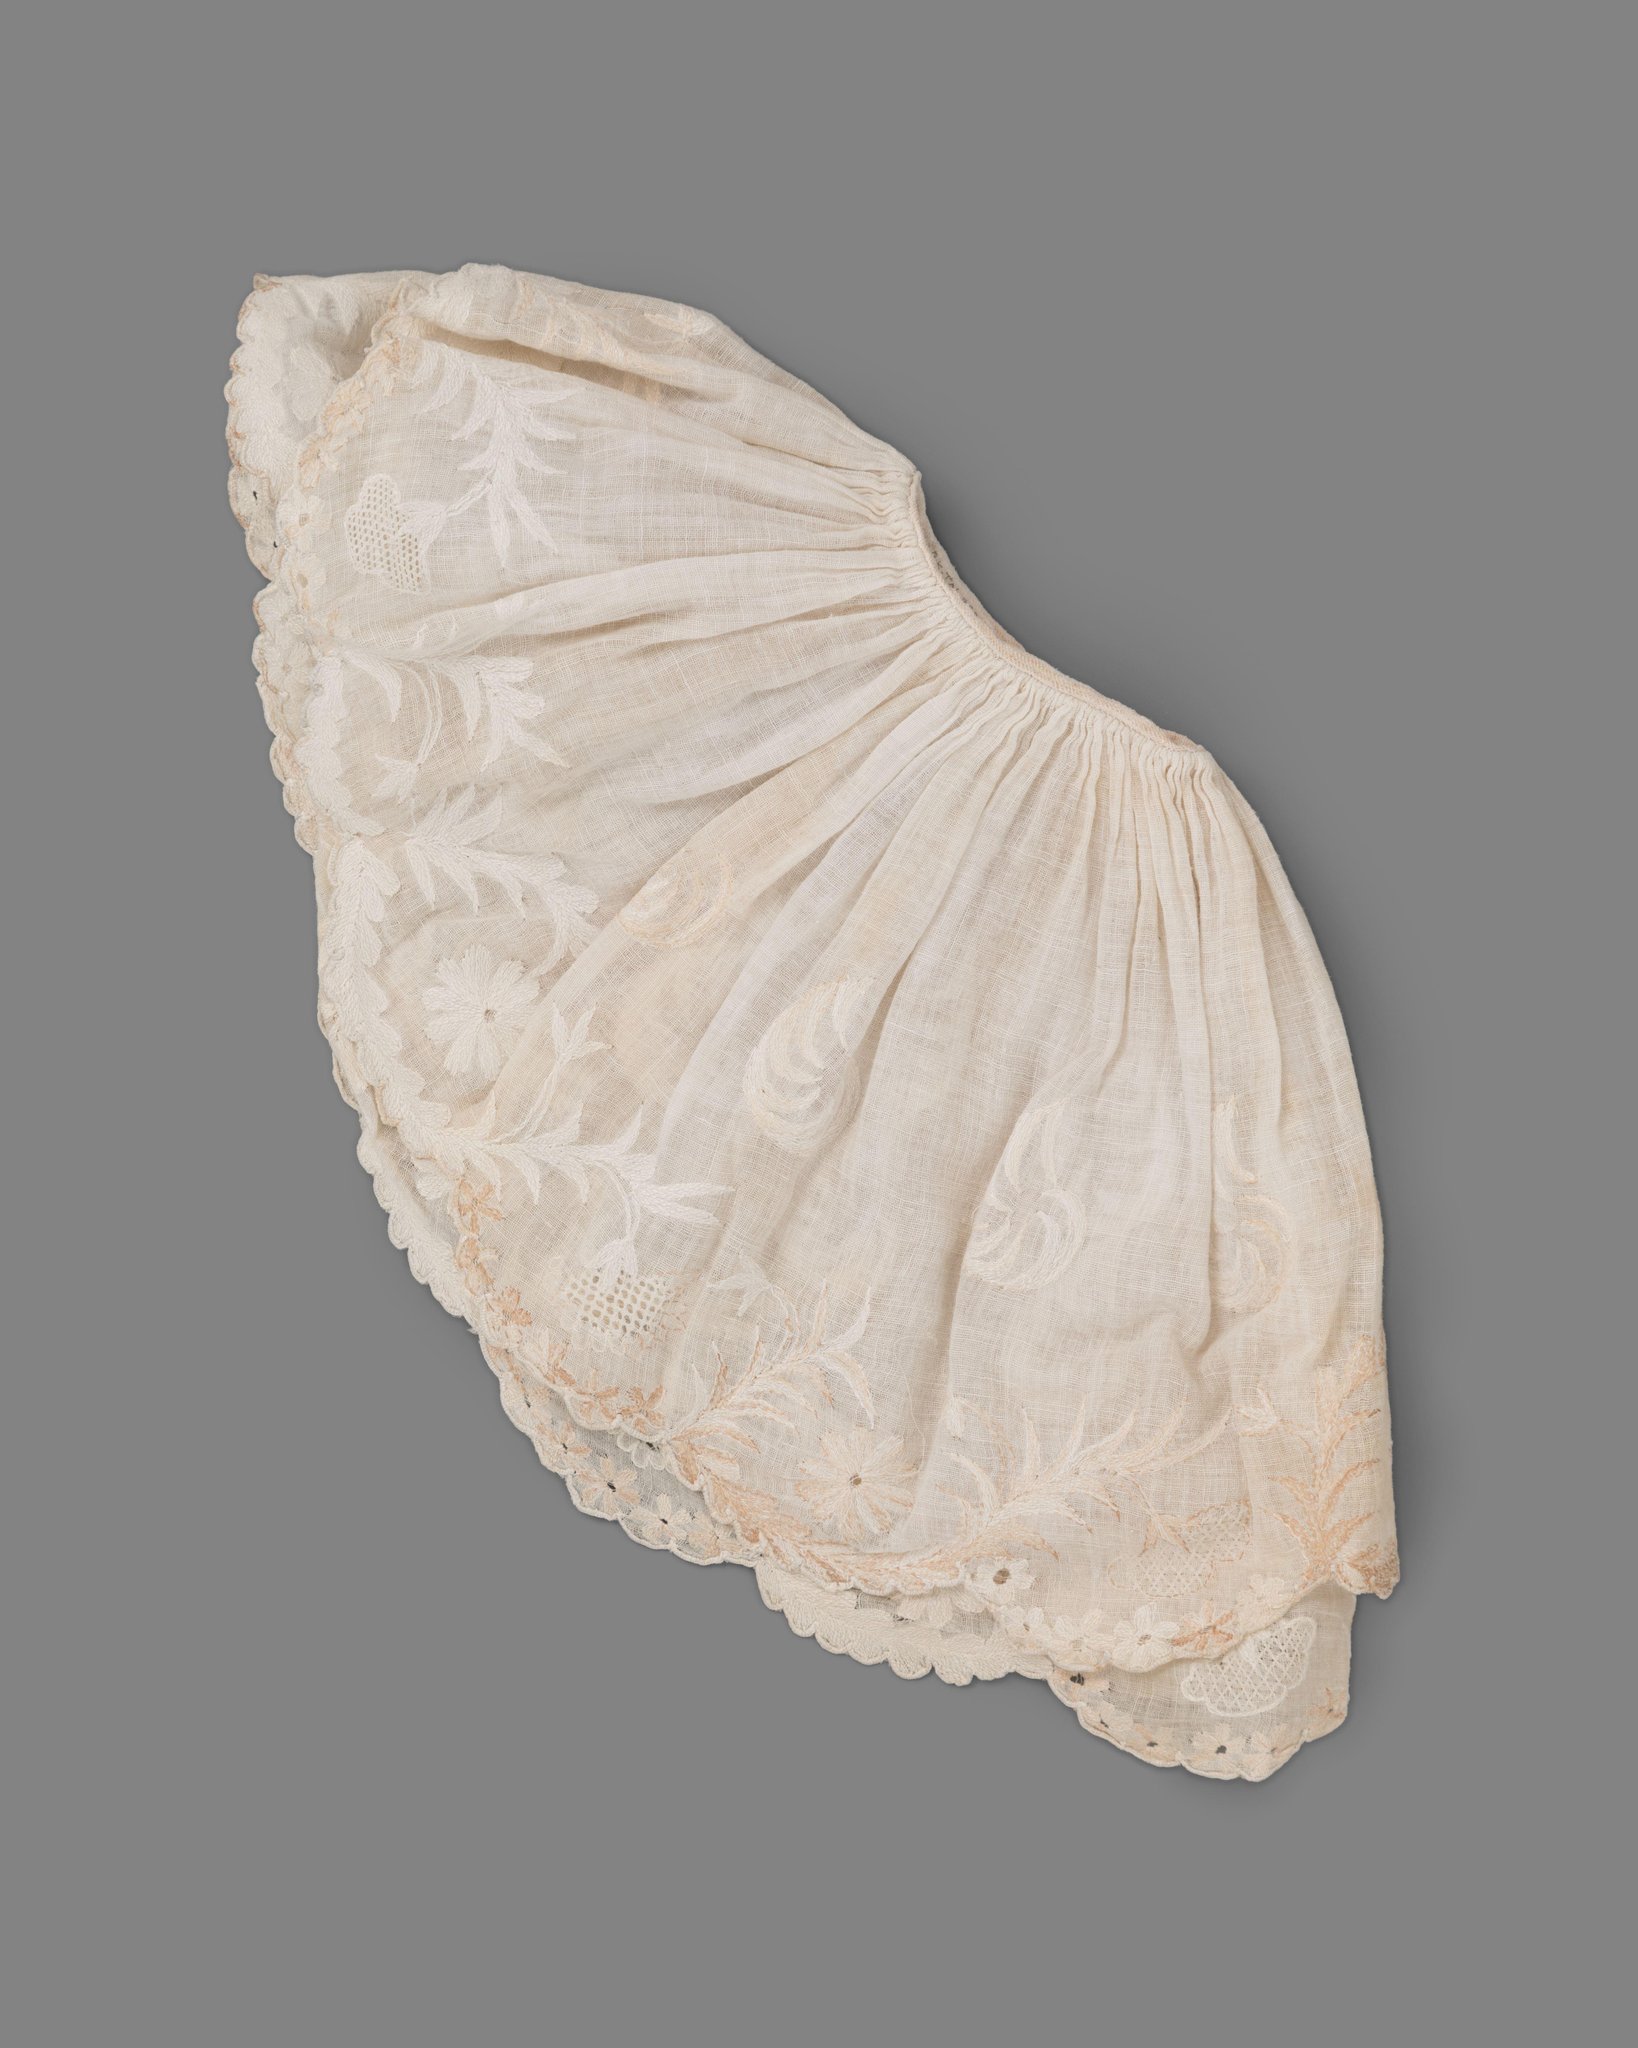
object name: engageante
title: Engageante bestaande uit twee lagen, geschulpt, en geborduurd met met grote bloemen aan golvende stengels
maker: Anonymous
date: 1700-1850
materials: linen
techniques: embroidered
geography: netherlands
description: Engageante bestaande uit twee lagen, geschulpt, en geborduurd met met grote bloemen aan golvende stengels.